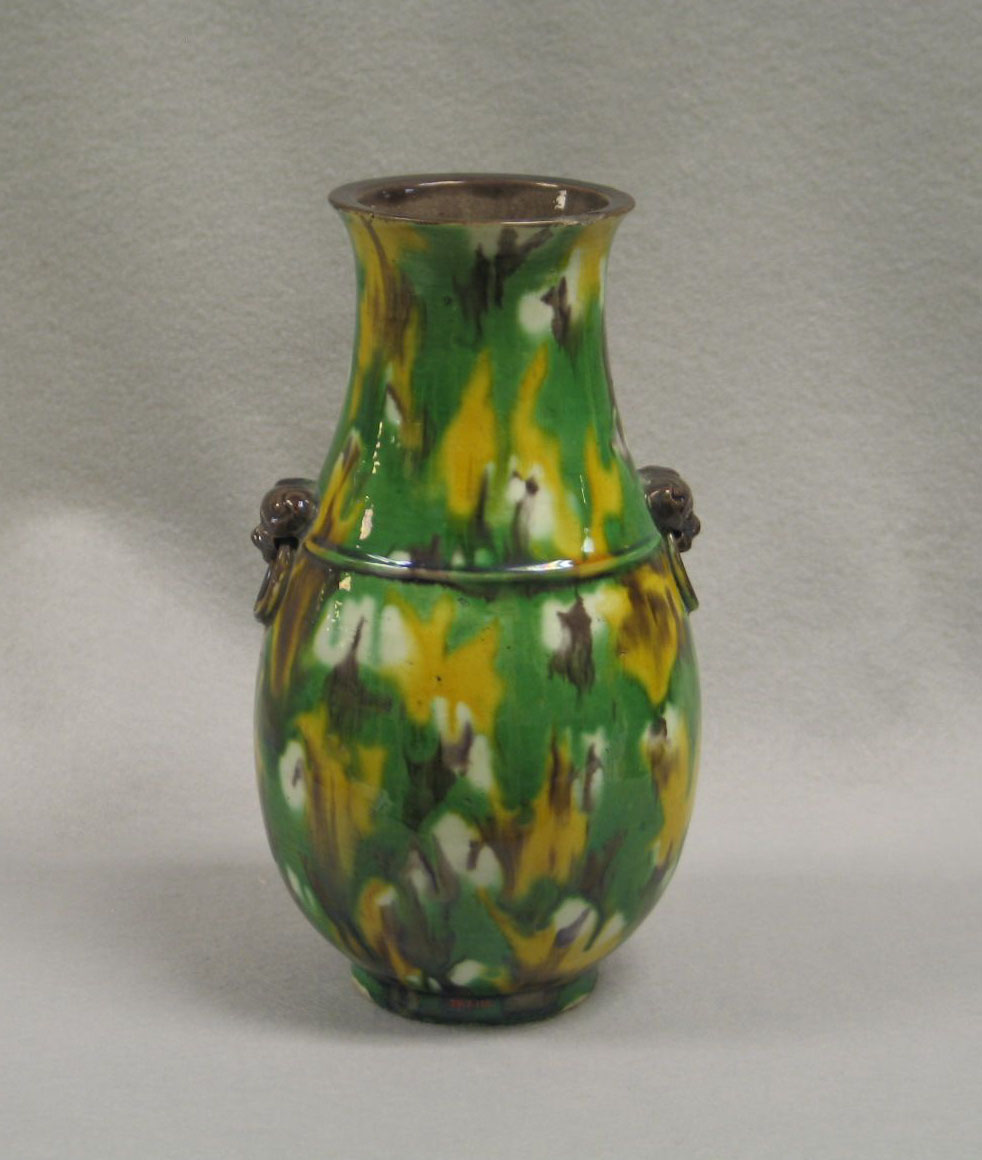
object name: vase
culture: chinese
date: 1701-1800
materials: glaze, porcelain